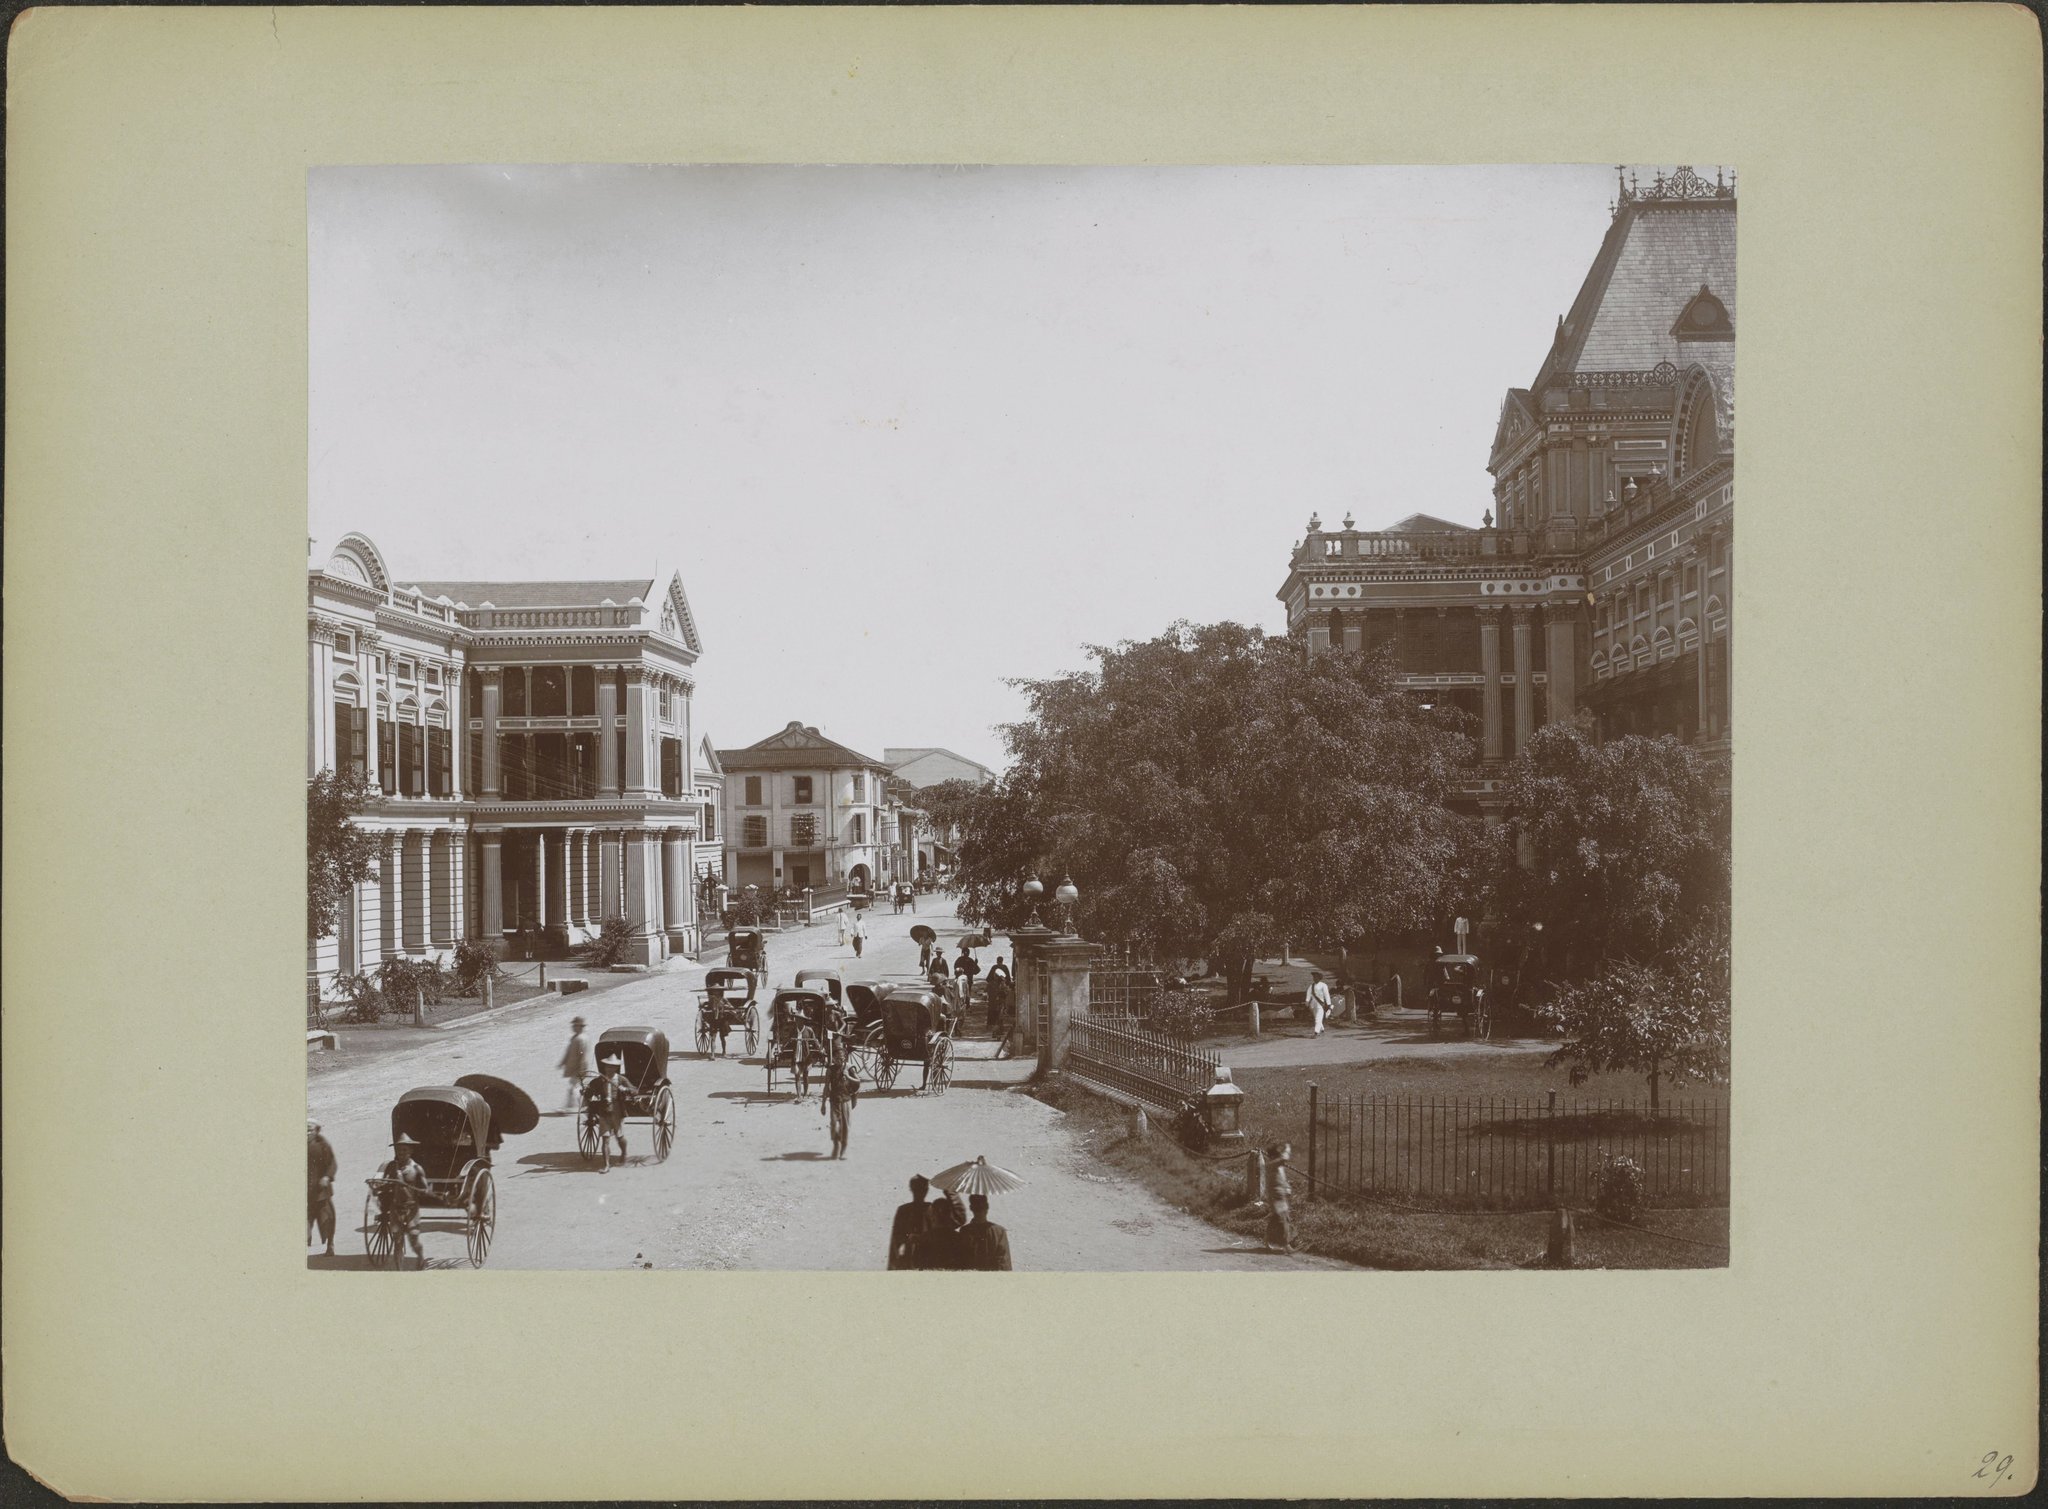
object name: album leaf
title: South Bridge Road in Singapore met riksja's en (rechts) het politiebureau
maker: Anonymous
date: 1870-1910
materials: cardboard, paper, photographic support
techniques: collodion silver print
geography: singapore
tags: rickshaw, exterior ~ representation of a building, street (+ city(-scape) with figures, staffage), singapore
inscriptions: inscription: ‘Singapore. Beroemde rickshaws.’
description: Onderdeel van Reisalbum met foto's van bezienswaardigheden in Marseille, Port Said, Aden, Bombay, Colombo, Singapore en Nederlands-Indië.